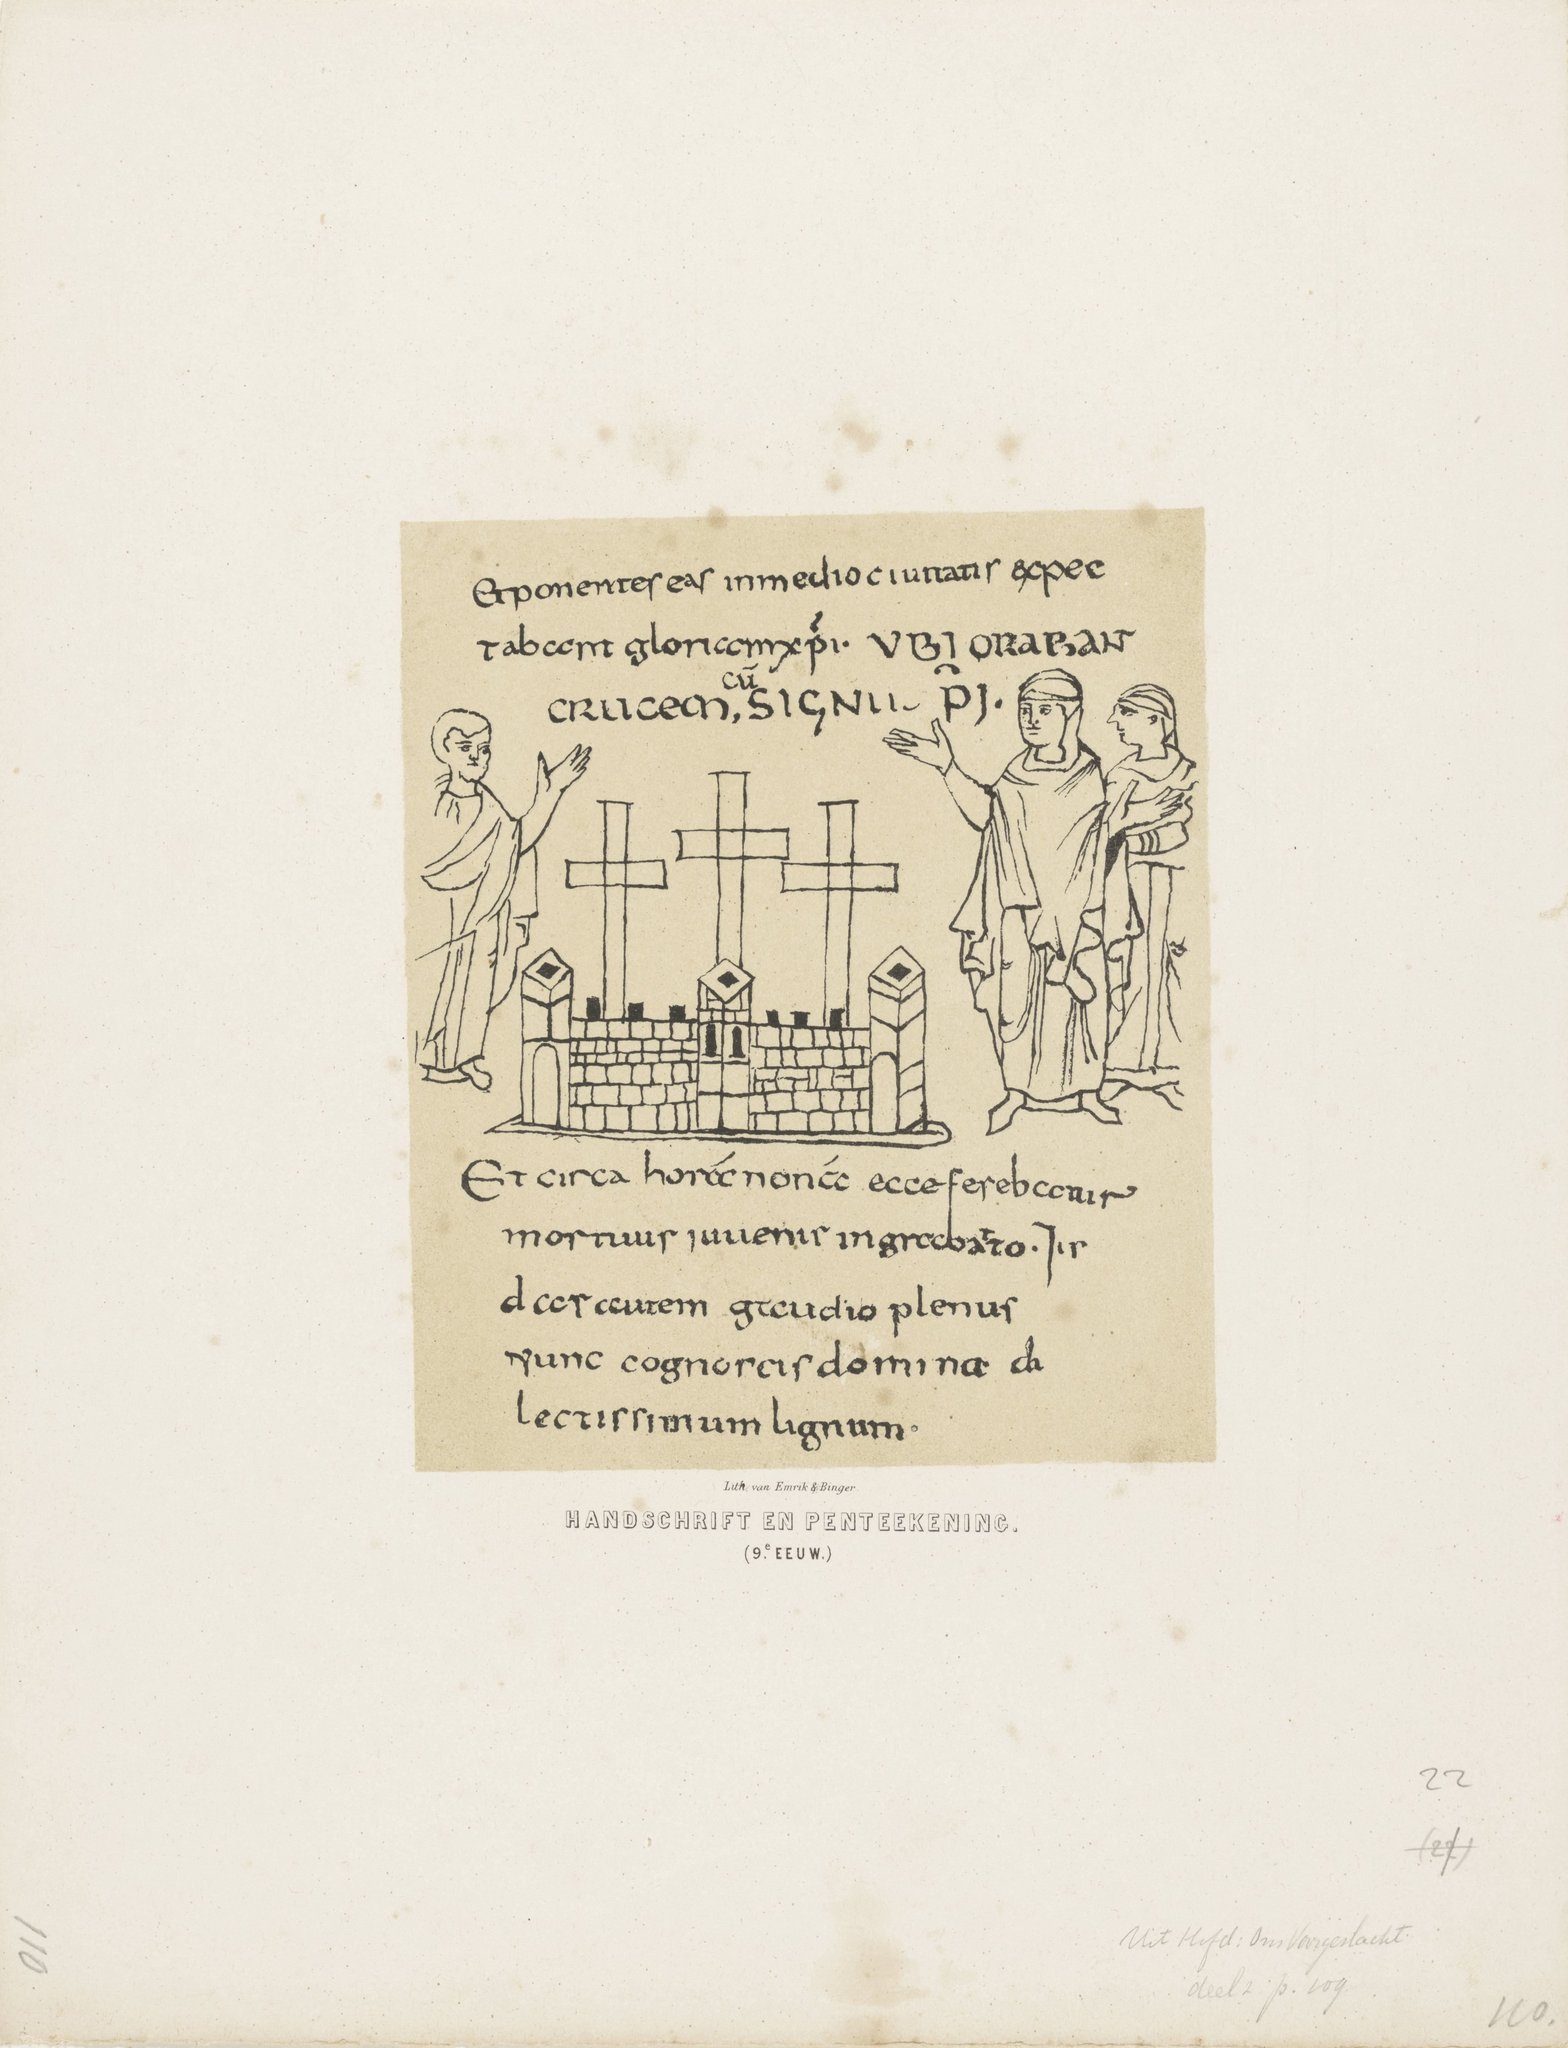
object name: print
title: Handschrift en penteekening. (9e eeuw)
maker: Anonymous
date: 1857-1864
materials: paper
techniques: tone lithography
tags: drawing, sketch, handwriting, written text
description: Illustratie voor: W.J. Hofdijk, Ons voorgeslacht in zijn dagelyksch leven geschilderd, Kruseman, Haarlem 1859-1864, dl. 2, p. 109.